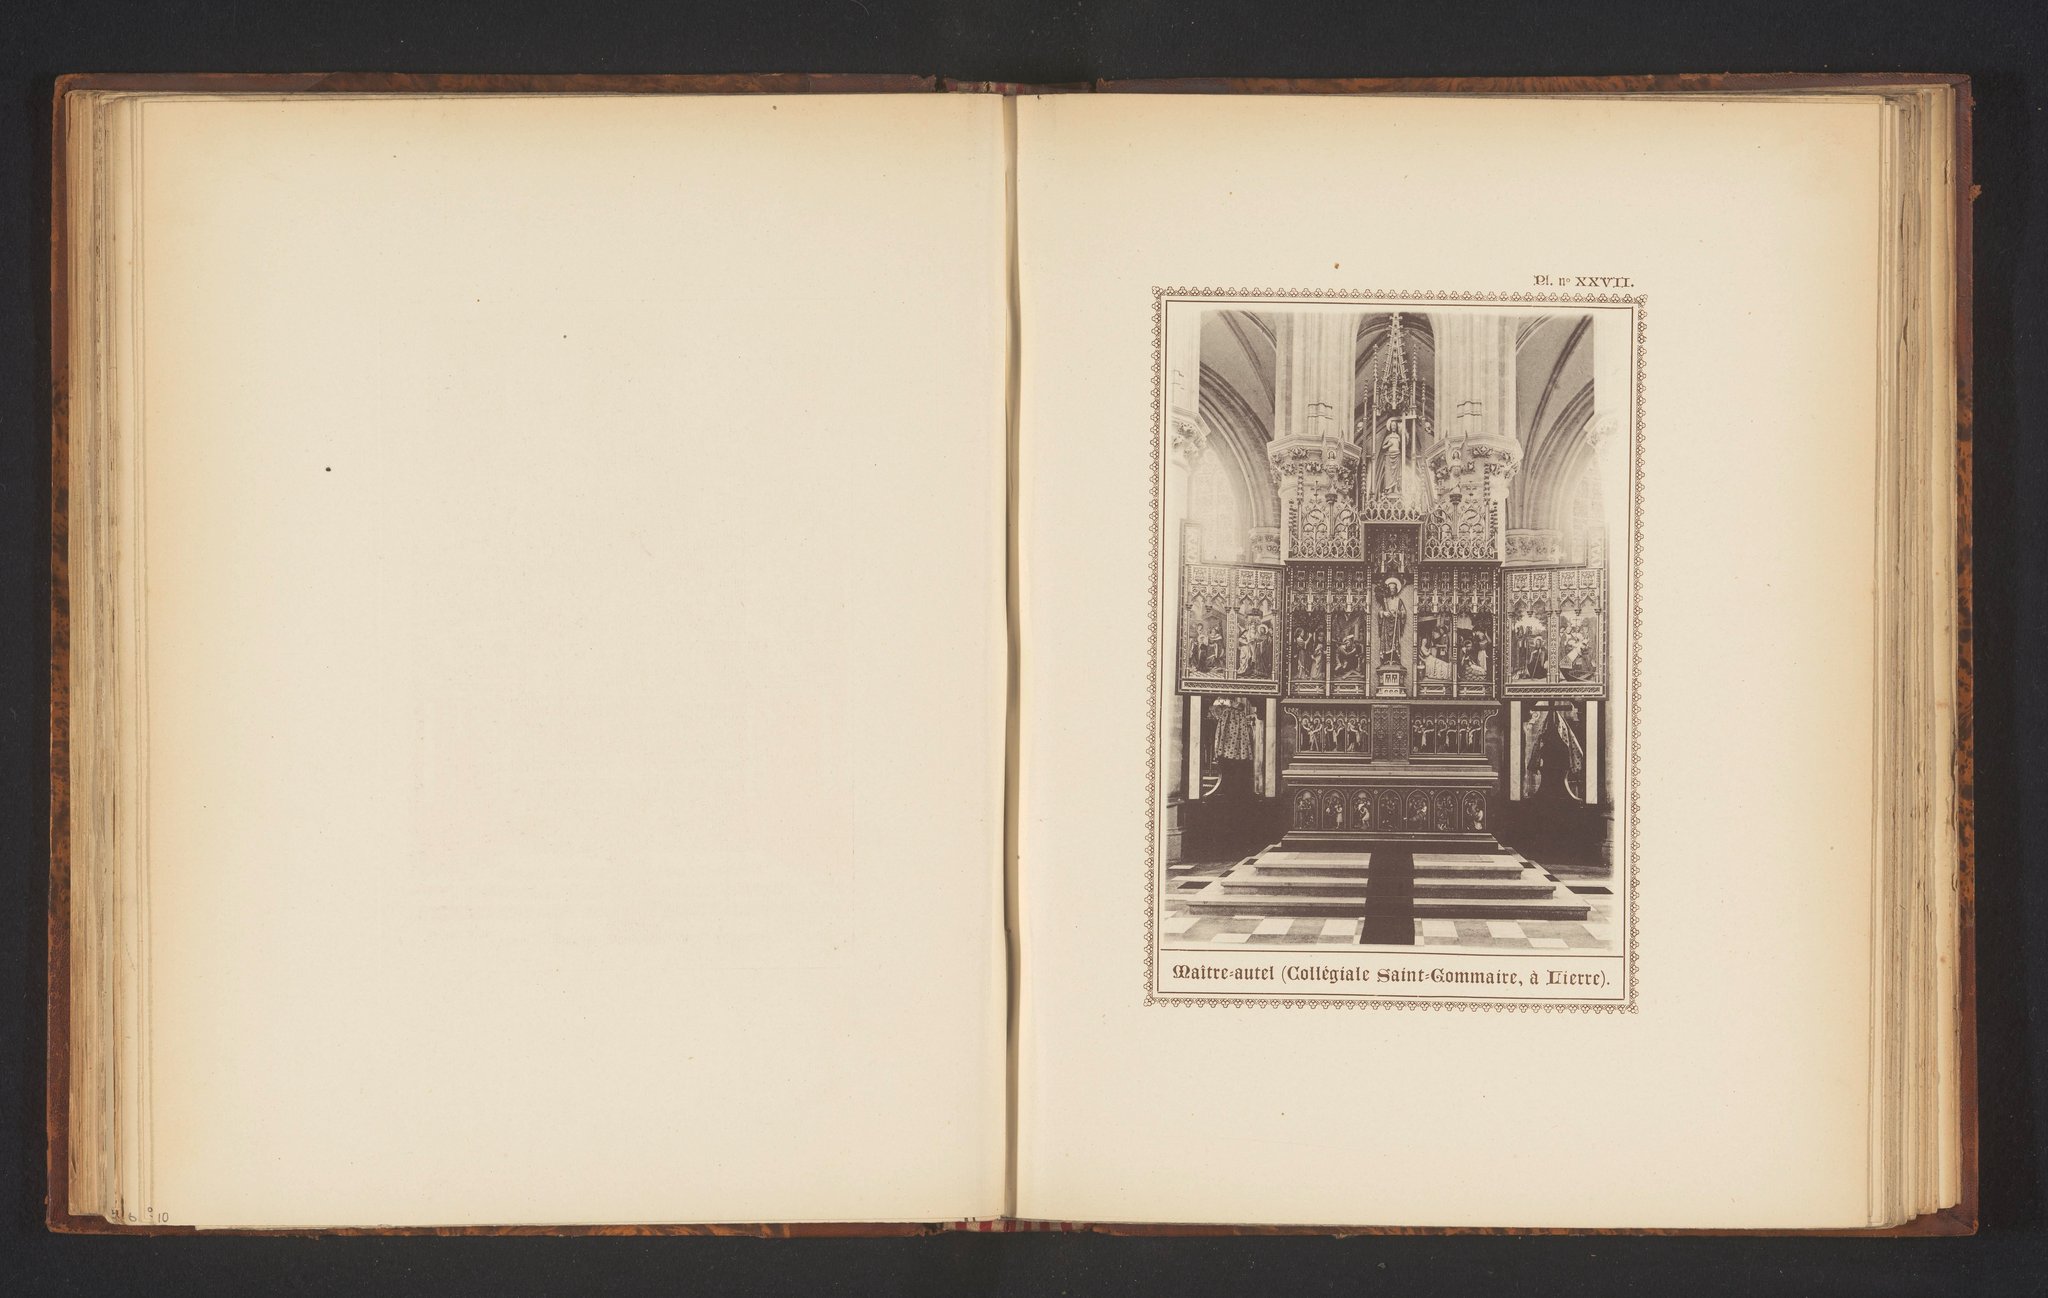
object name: photomechanical print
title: Maître-Autel (Collégiale Saint-Gommaire, à Lierre)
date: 1891-1896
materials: paper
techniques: photograph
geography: lierre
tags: altar with altar-piece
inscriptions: number: ‘Pl. no XXVII.’